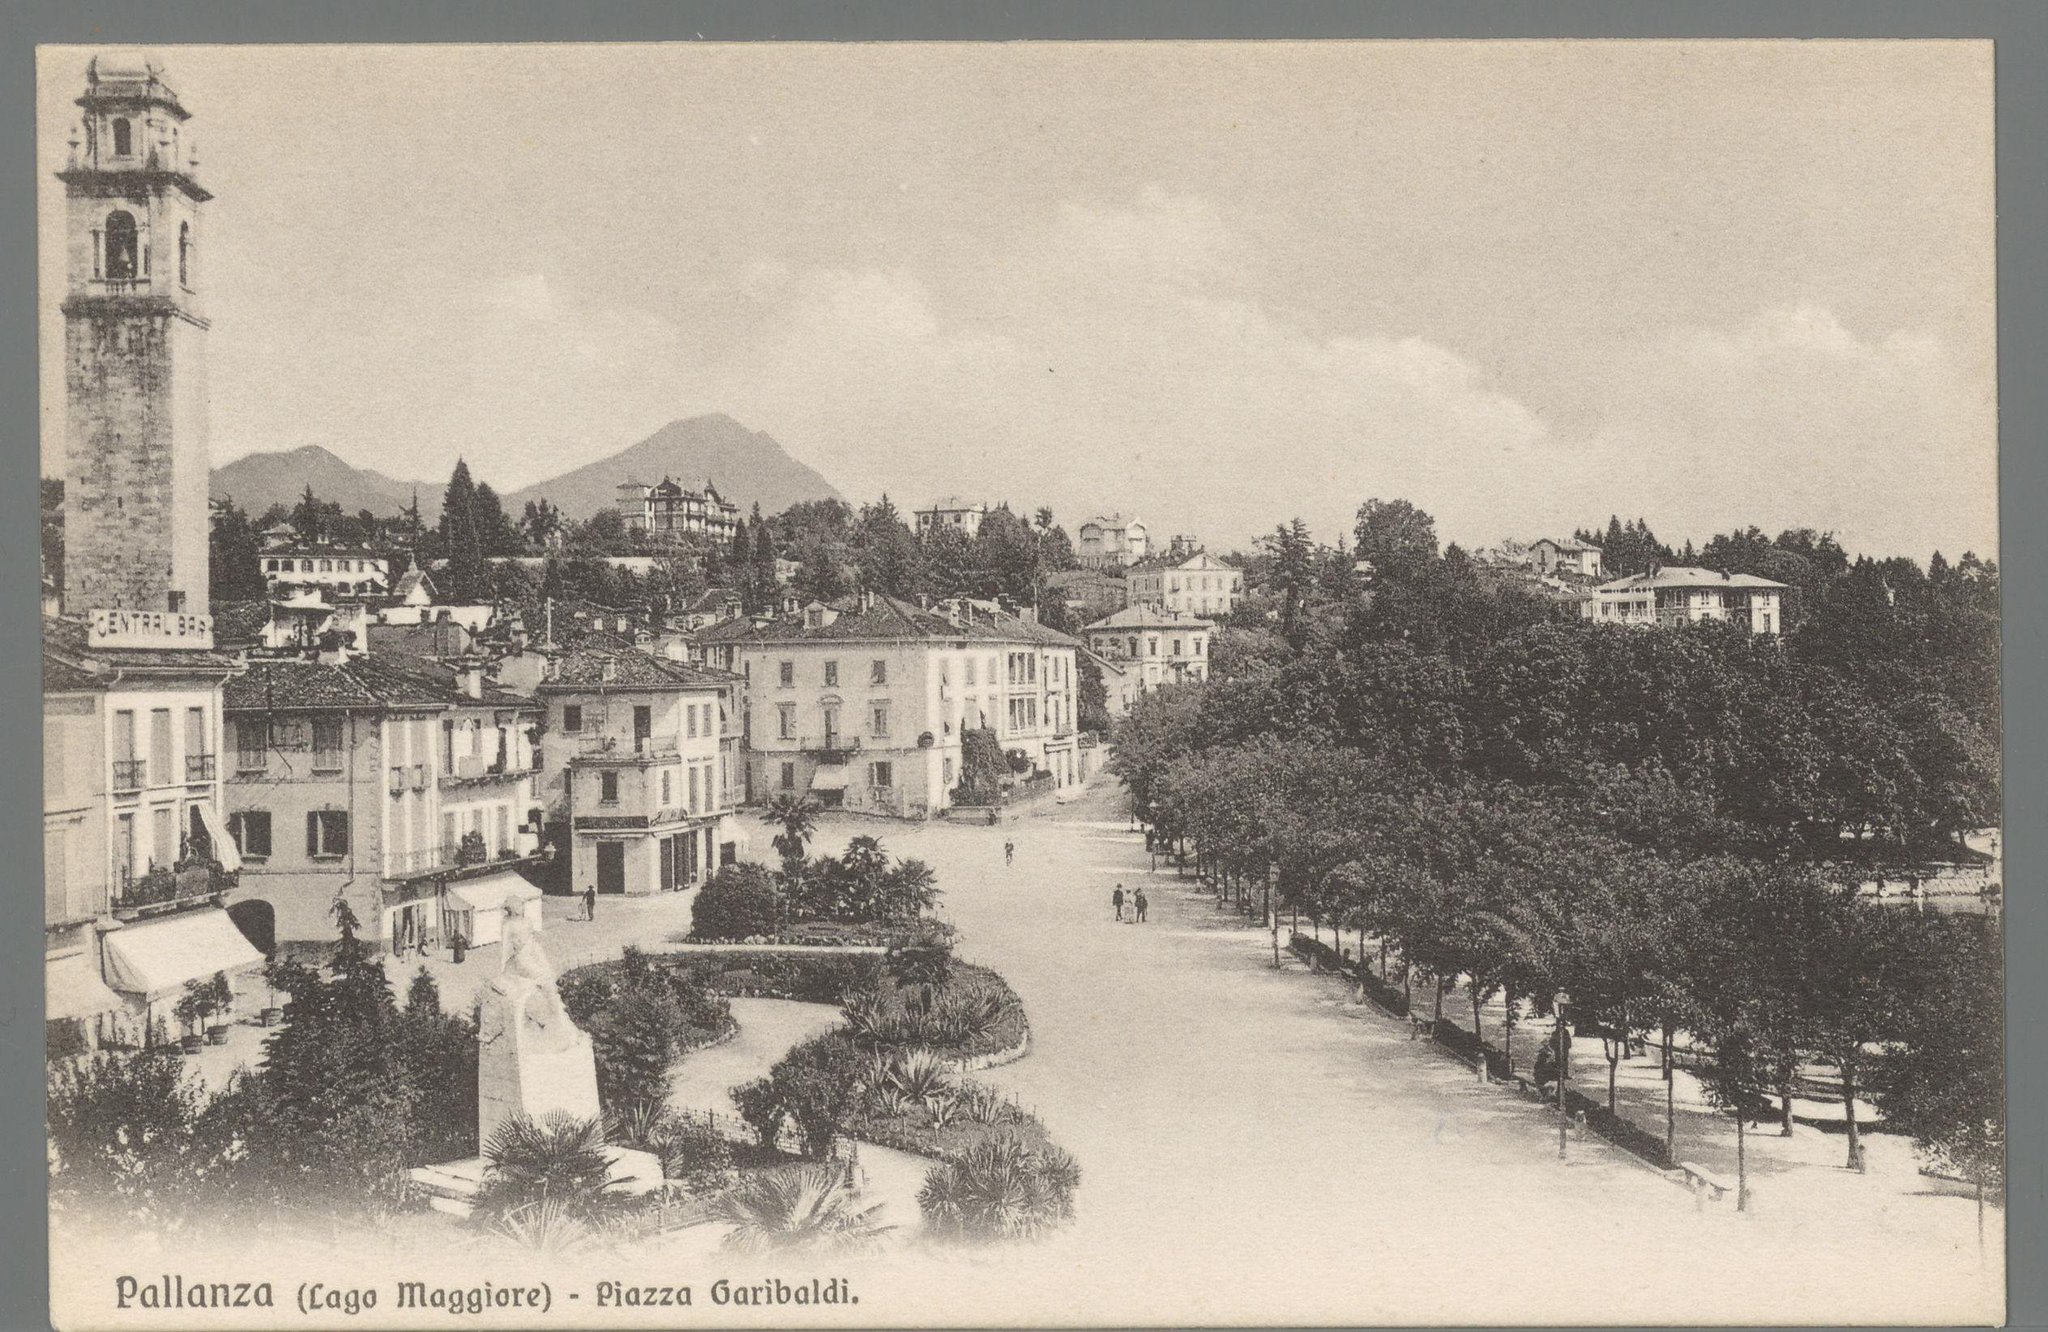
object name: photomechanical print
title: Pallanza (Lago Maggiore). Piazza Garibaldi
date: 1906-1909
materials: cardboard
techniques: photograph, writing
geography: pallanza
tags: square, place, circus, etc. (+ city(-scape) with figures, staffage), mountains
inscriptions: monogram: ‘S.G.’